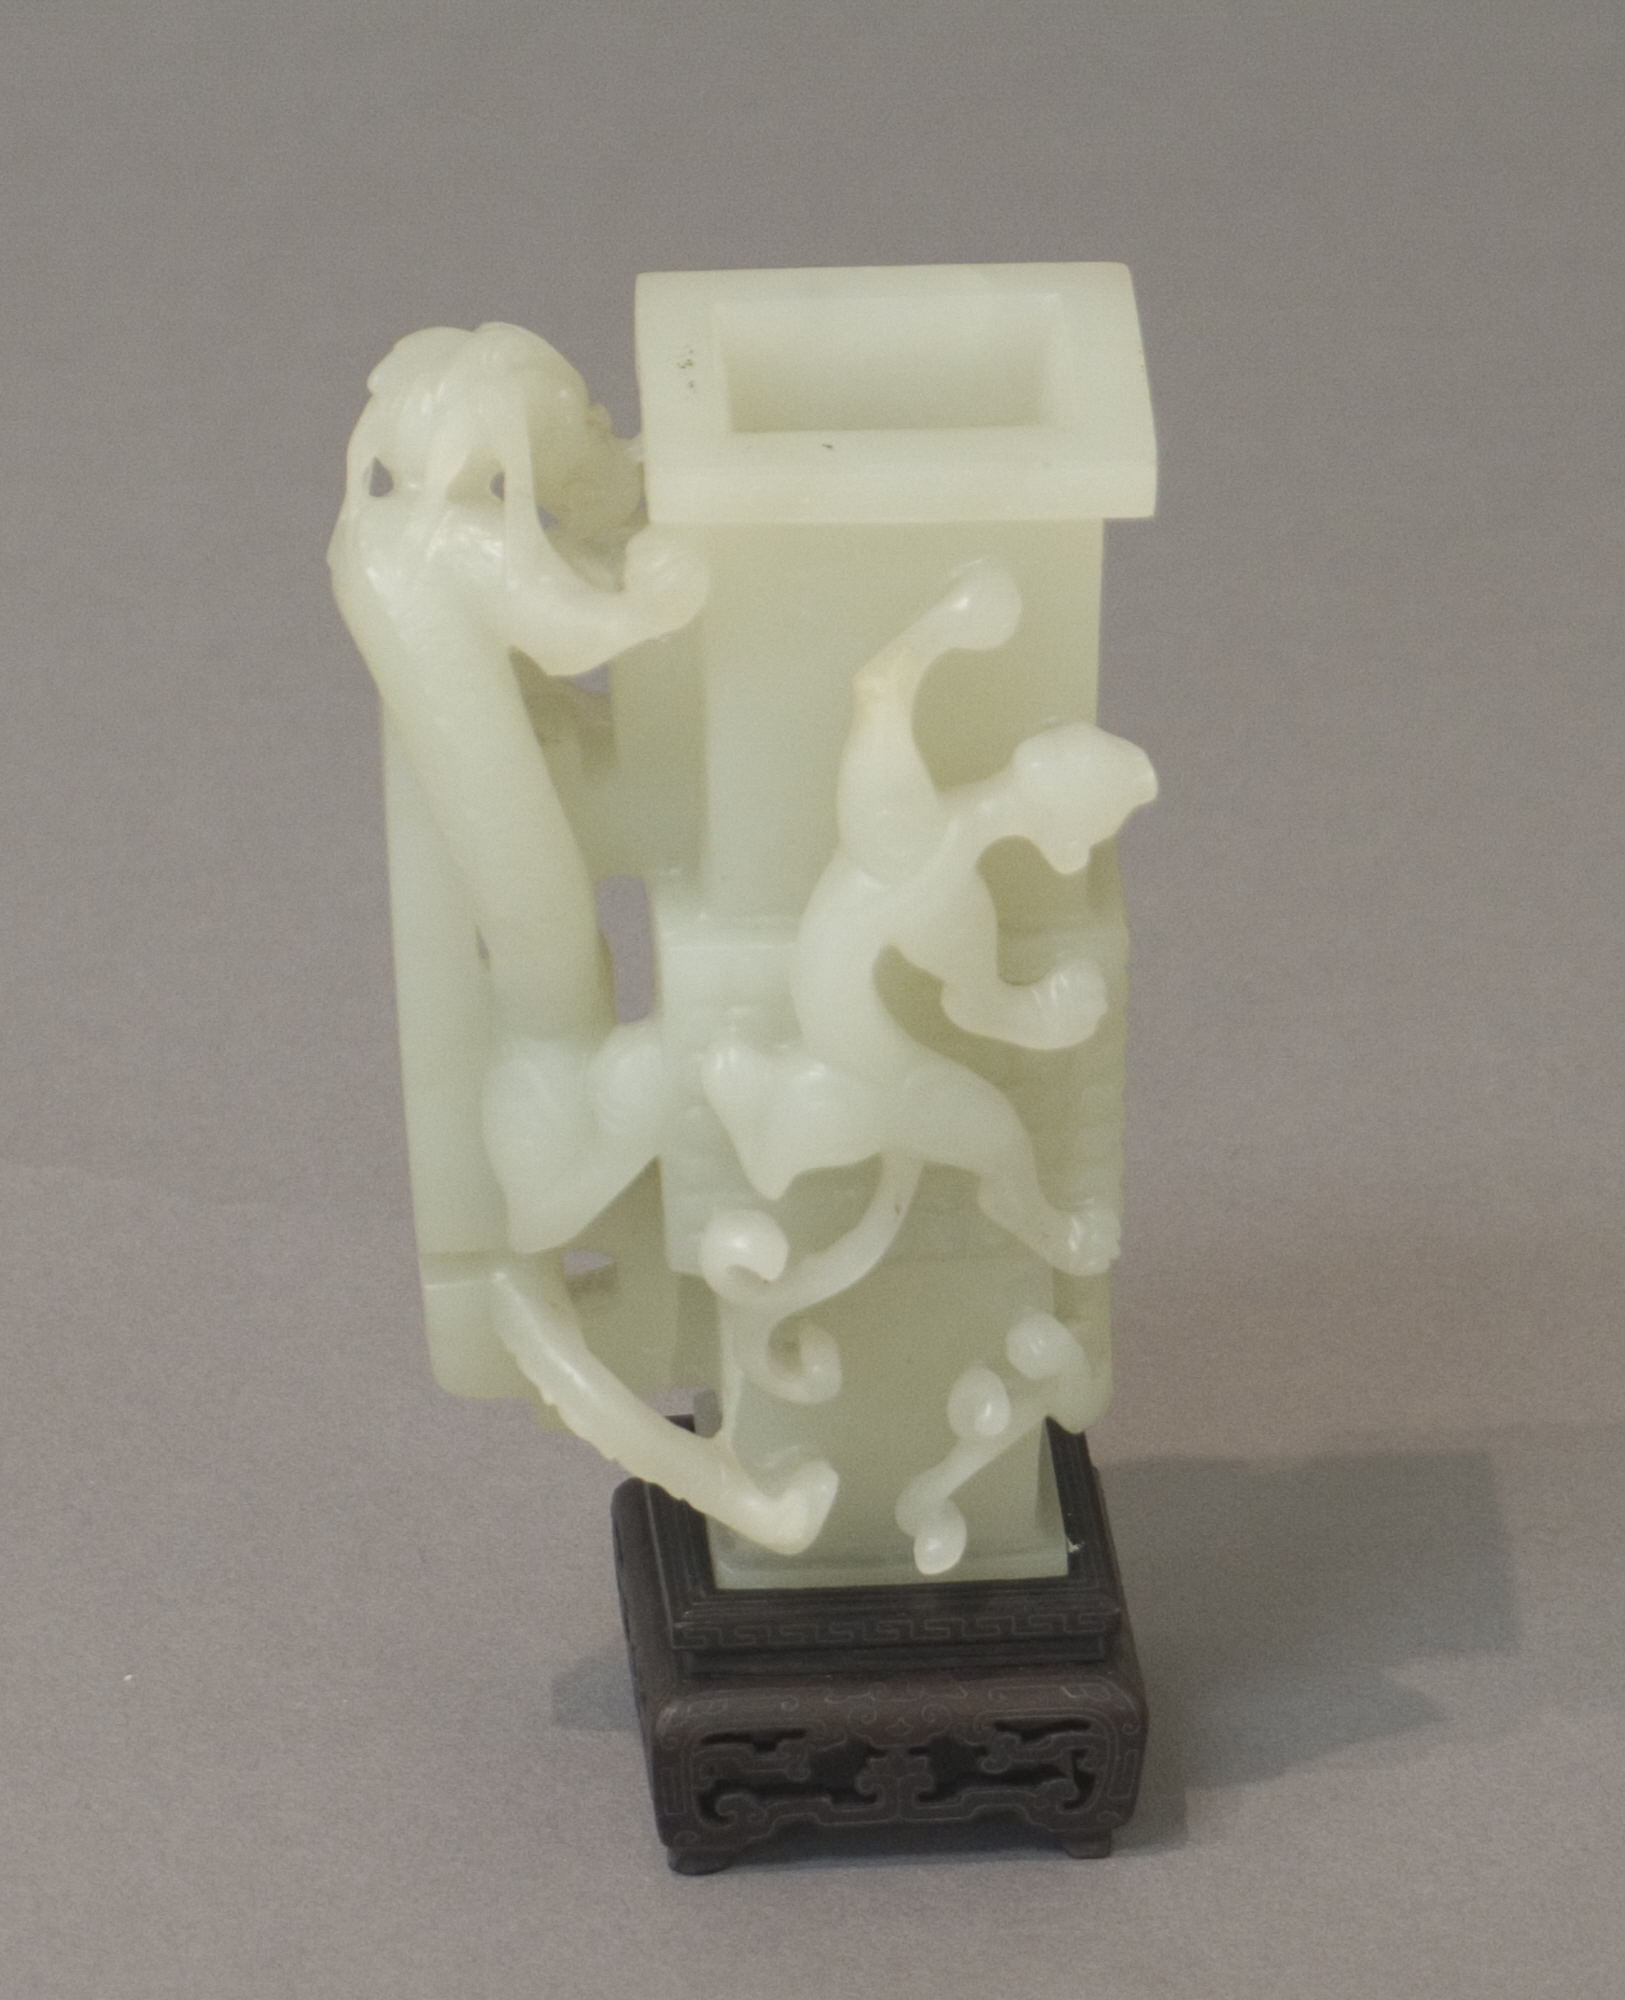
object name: vase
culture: chinese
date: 1368-1644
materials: jade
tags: mythical creatures